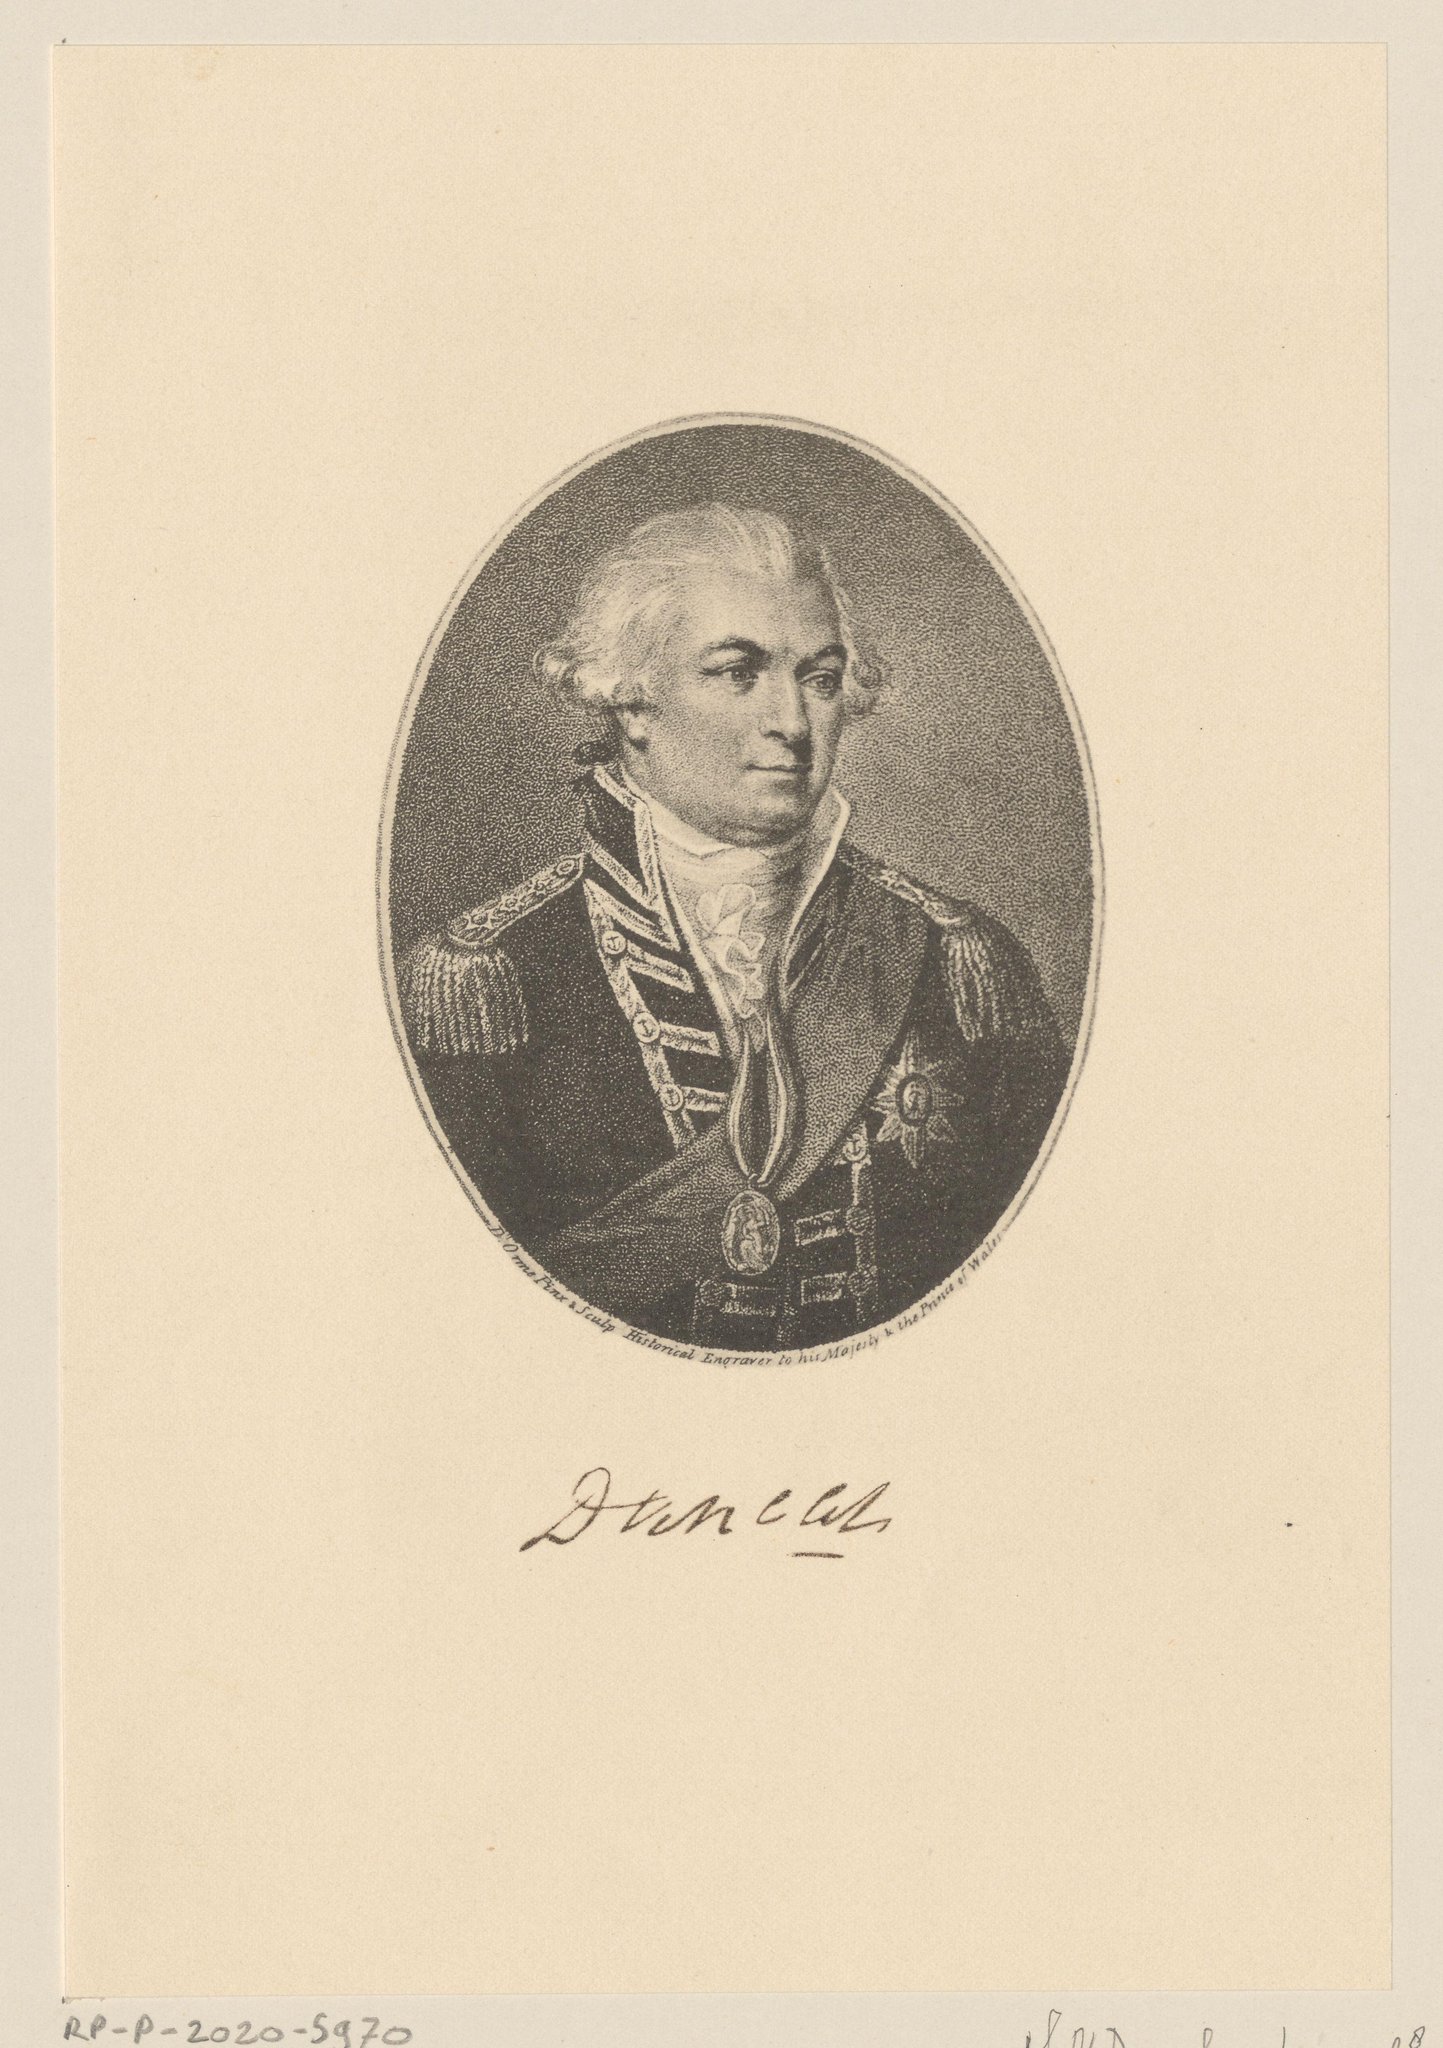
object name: photomechanical print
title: Reproductie van een prent van een portret van Adam Duncan door Daniel Orme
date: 1875-1920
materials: paper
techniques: photograph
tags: adam duncan (burggraaf van duncan), historical persons, commander-in-chief, admiral